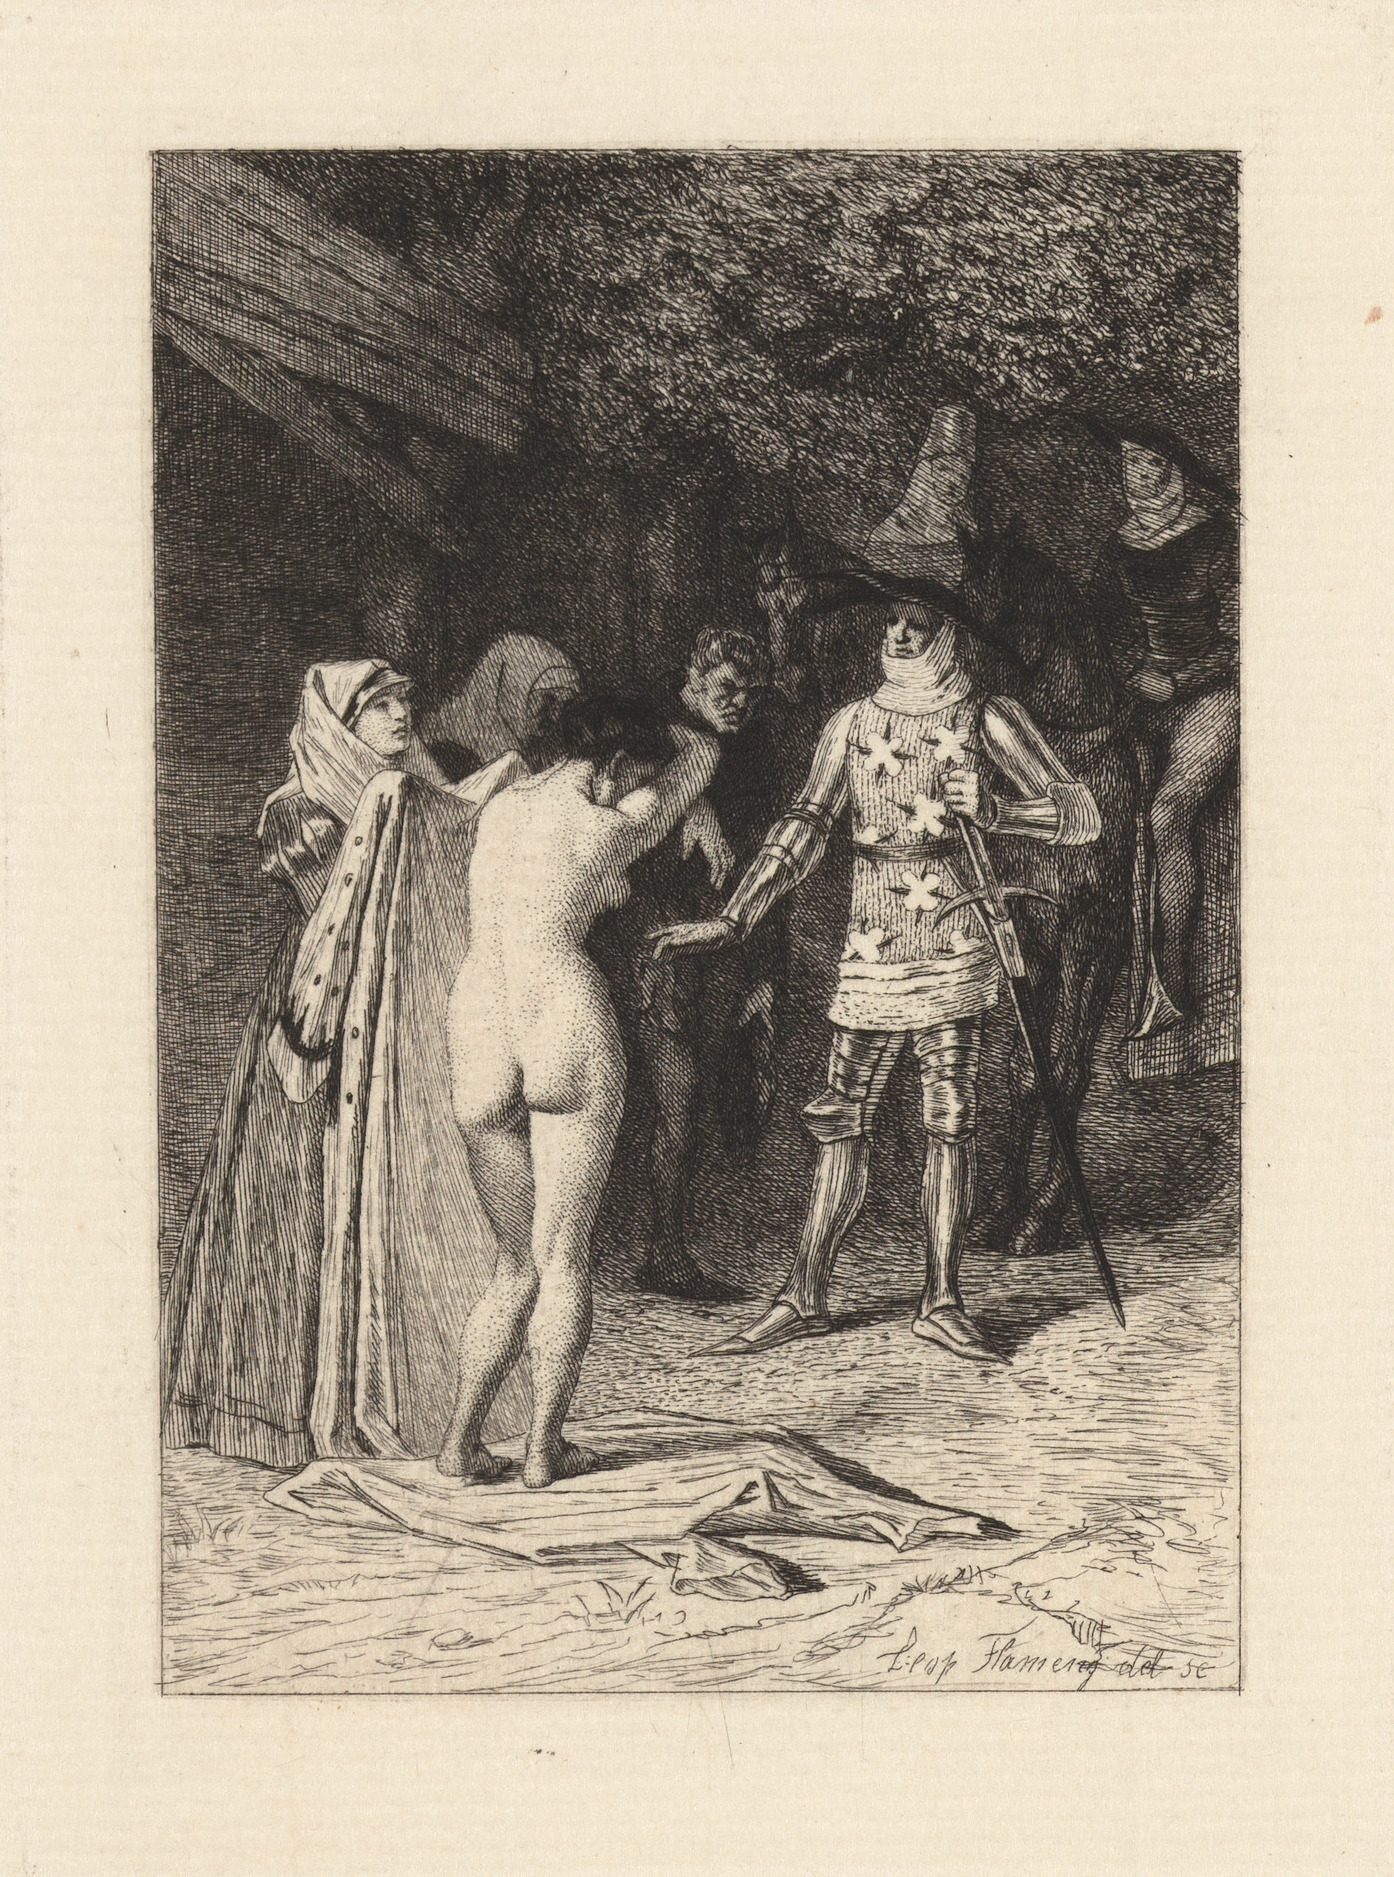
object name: print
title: Grisélidis, plate 10 from "The Decameron"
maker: léopold flameng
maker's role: engraver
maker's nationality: french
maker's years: 1831-1911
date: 1873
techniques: etching